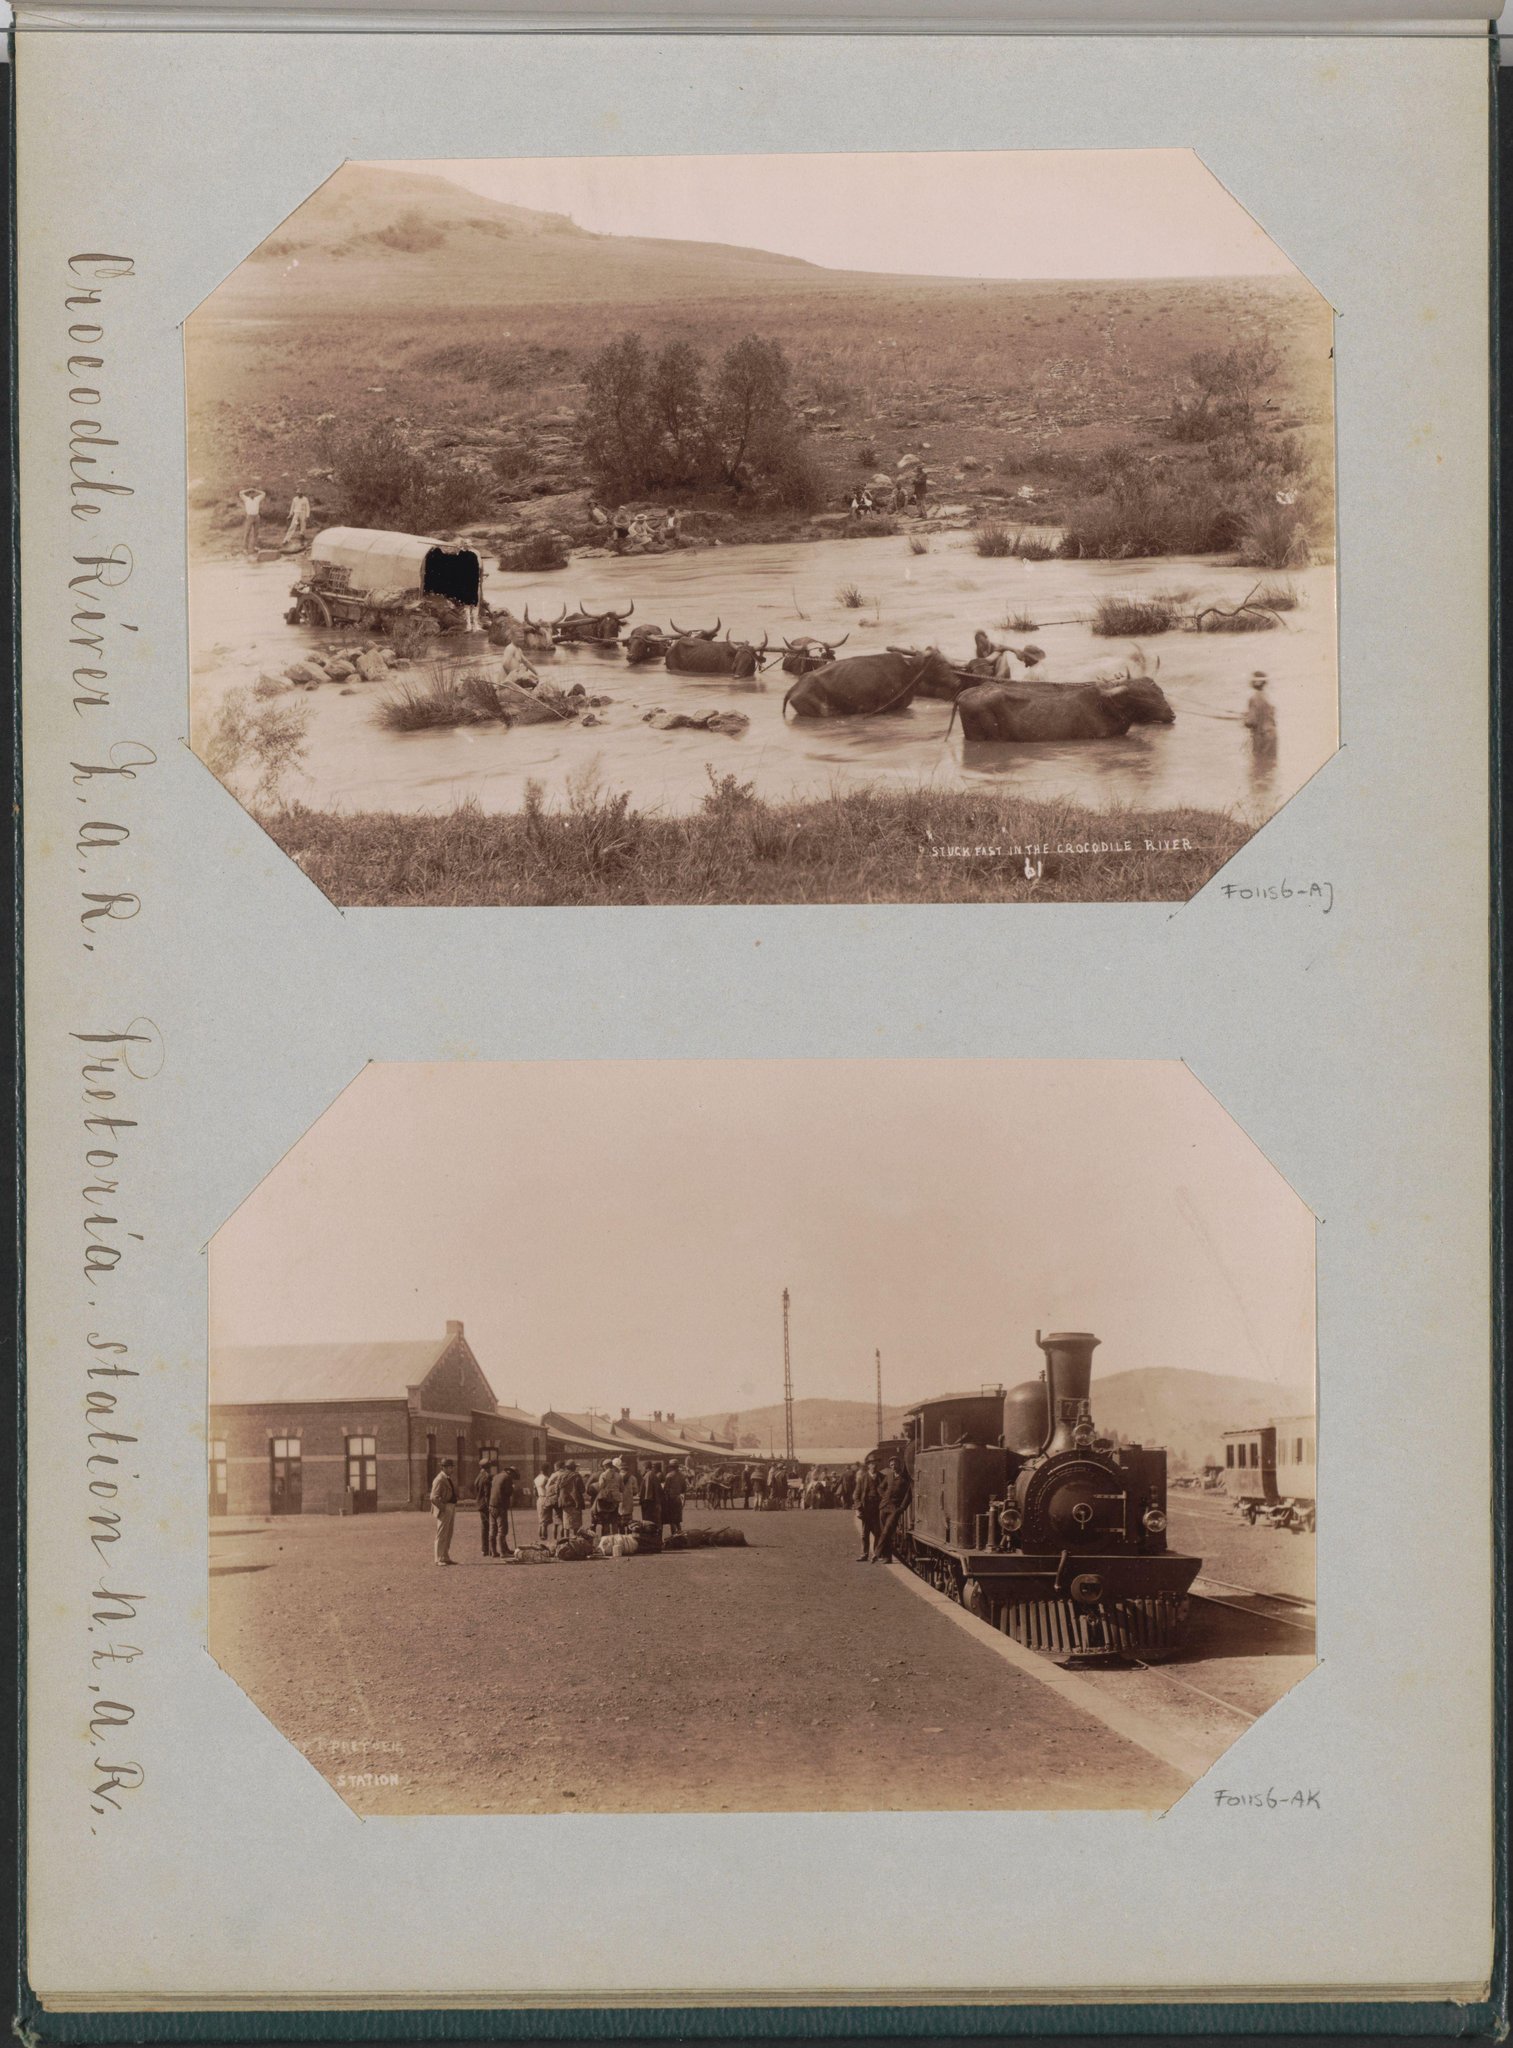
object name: album leaf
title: Gezicht op het treinstation van Pretoria met locomotief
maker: Anonymous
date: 1886-1896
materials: photographic support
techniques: albumen print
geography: pretoria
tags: station; shelter (railway, tramway), steam locomotive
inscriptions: annotation: ‘Crocodile River Z.A.R. Pretoria station N.Z.A.R.’